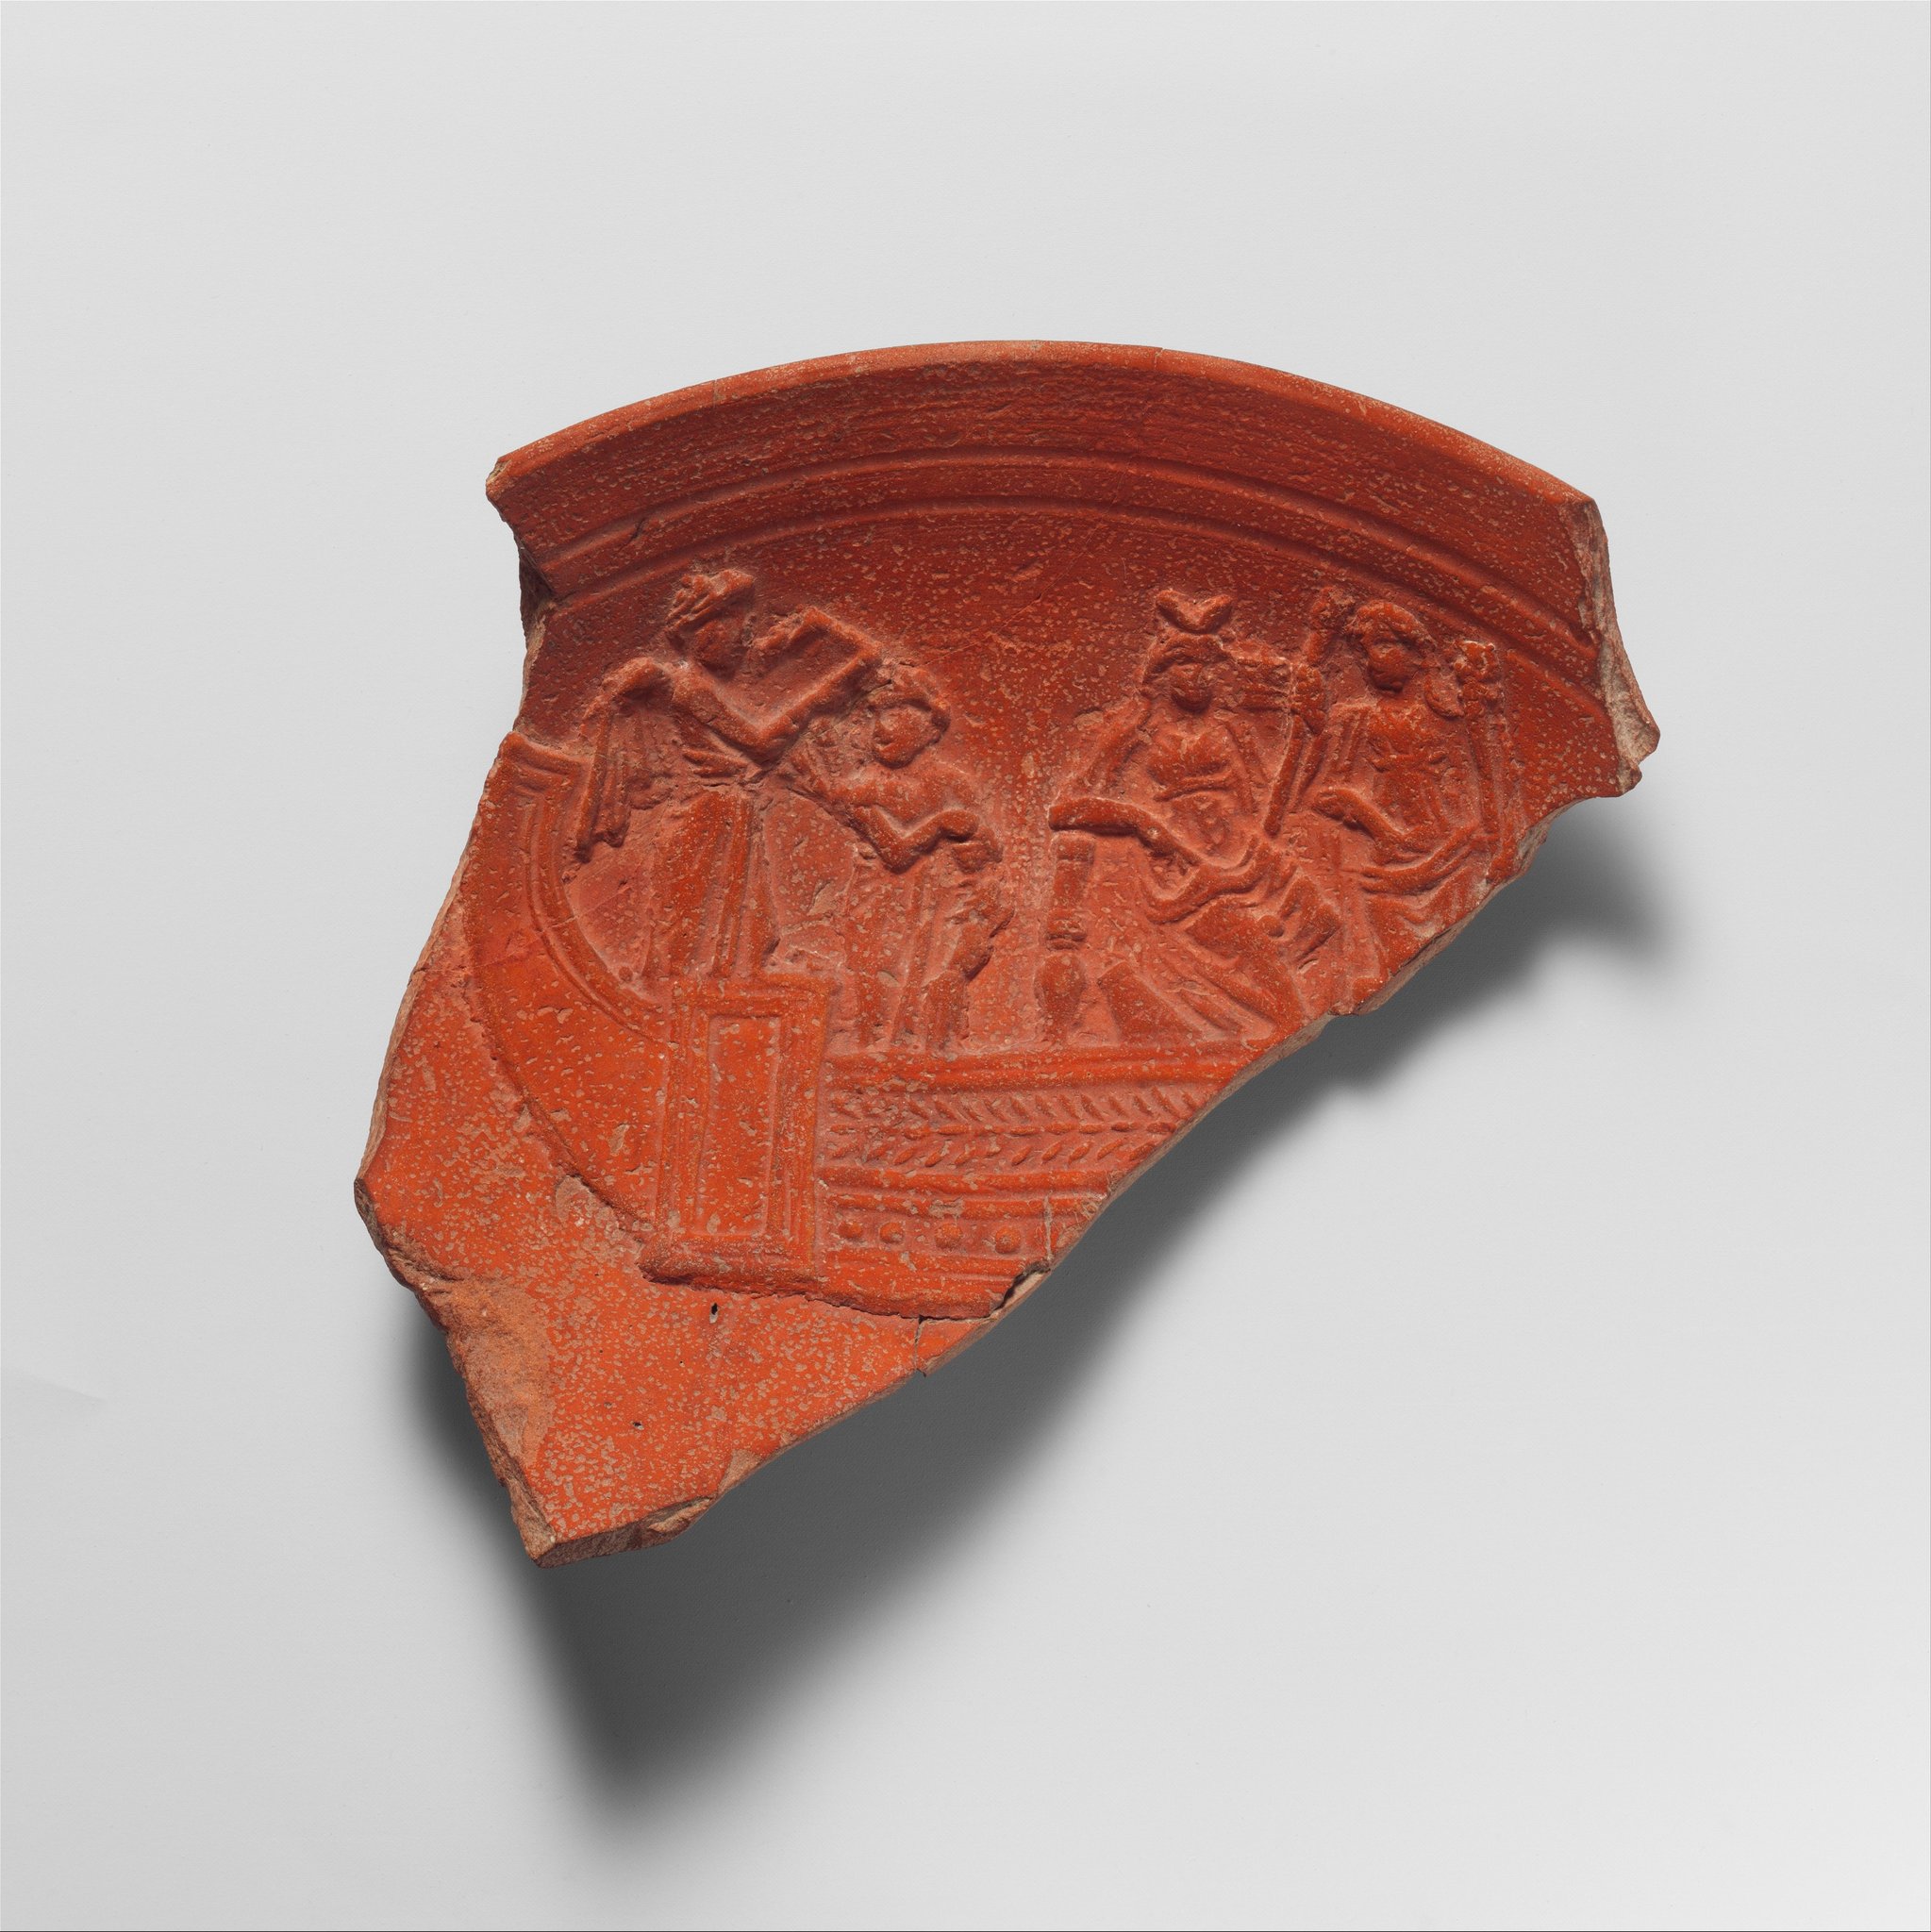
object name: fragment of a bowl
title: Terracotta bowl fragment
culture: roman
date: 350-430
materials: terracotta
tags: cupid,isis,boats